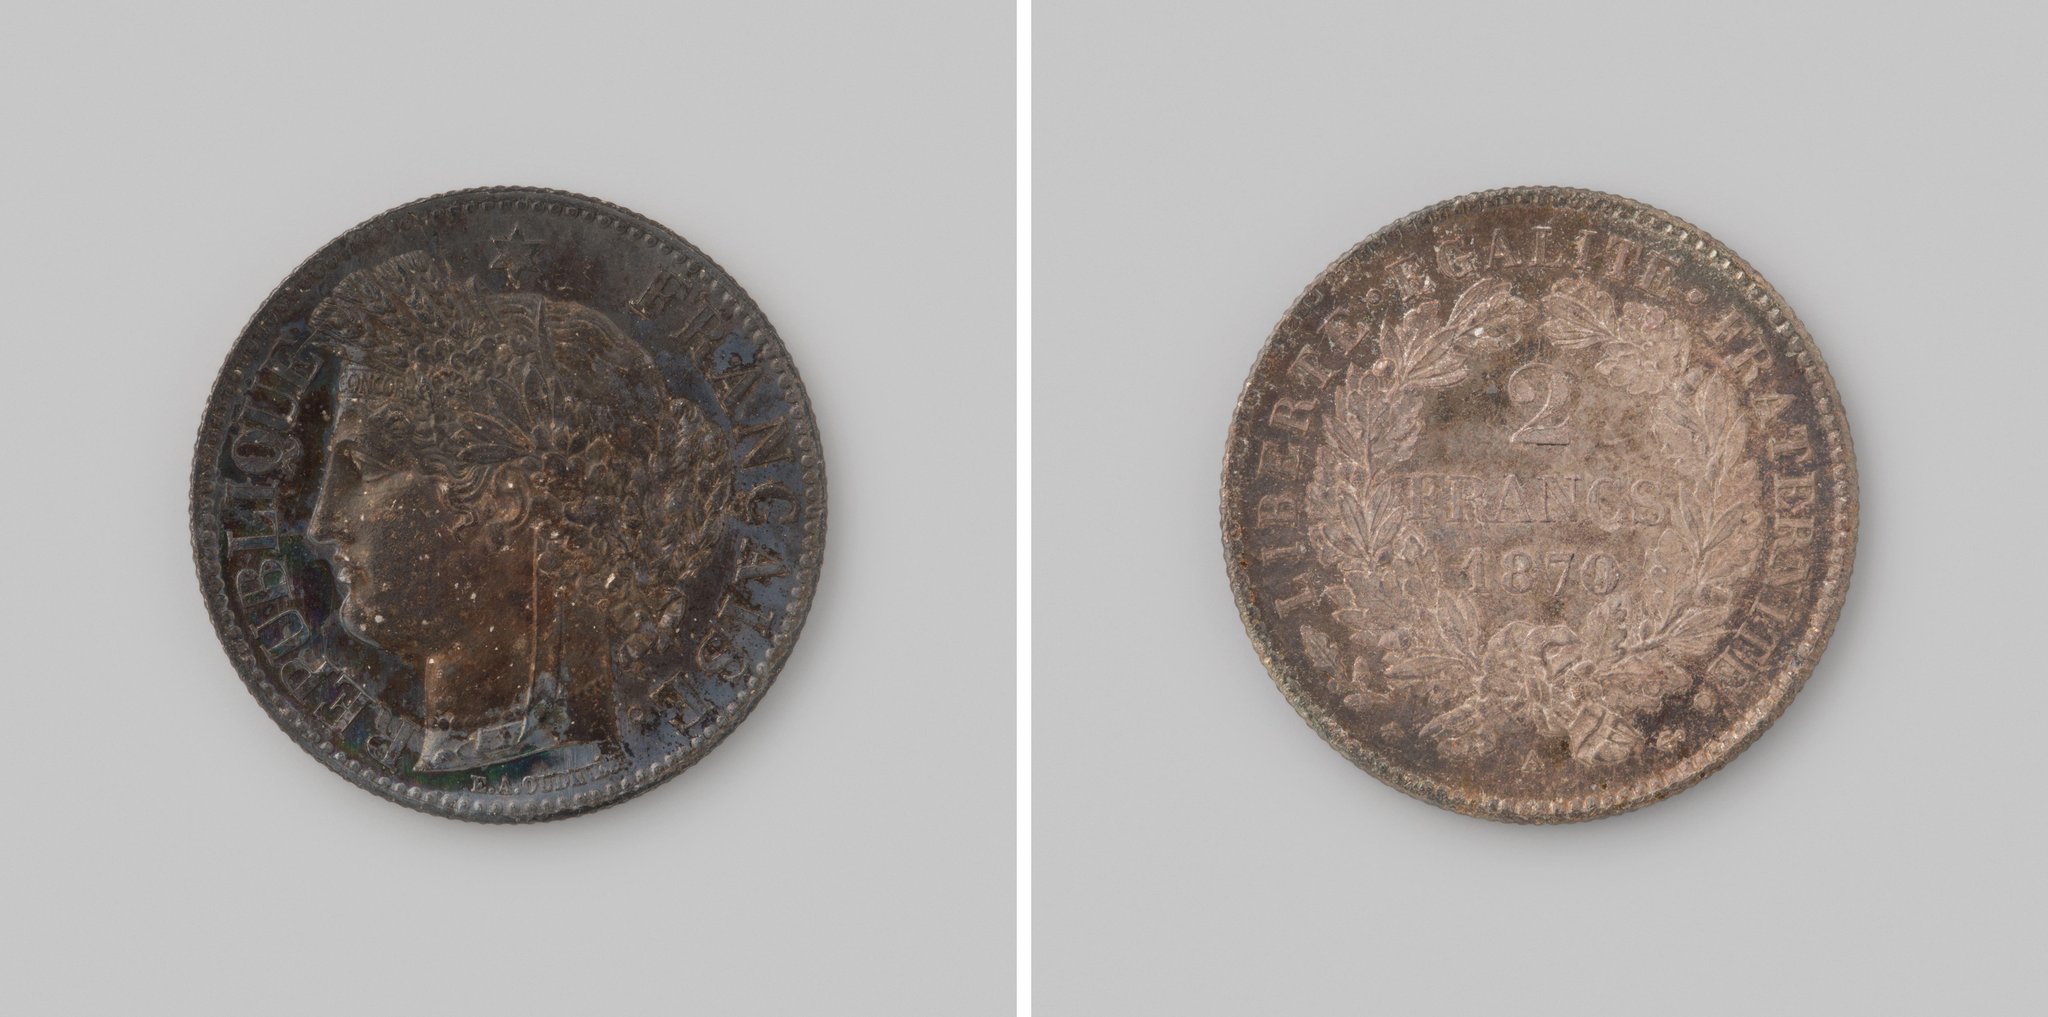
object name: coin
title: Frankrijk, Derde Republiek, 2 francs,1870 A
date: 1870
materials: silver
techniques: striking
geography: paris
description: Zilveren munt. Voorzijde: portret van een vrouw met krans en diadeem naar links. Bovenaan ster. Keerzijde: binnen twee samengebonden takken waarde-aanduiding in twee regels, waaronder jaartal. Onderaan de letter A [=Parijs]. Kartelrand.